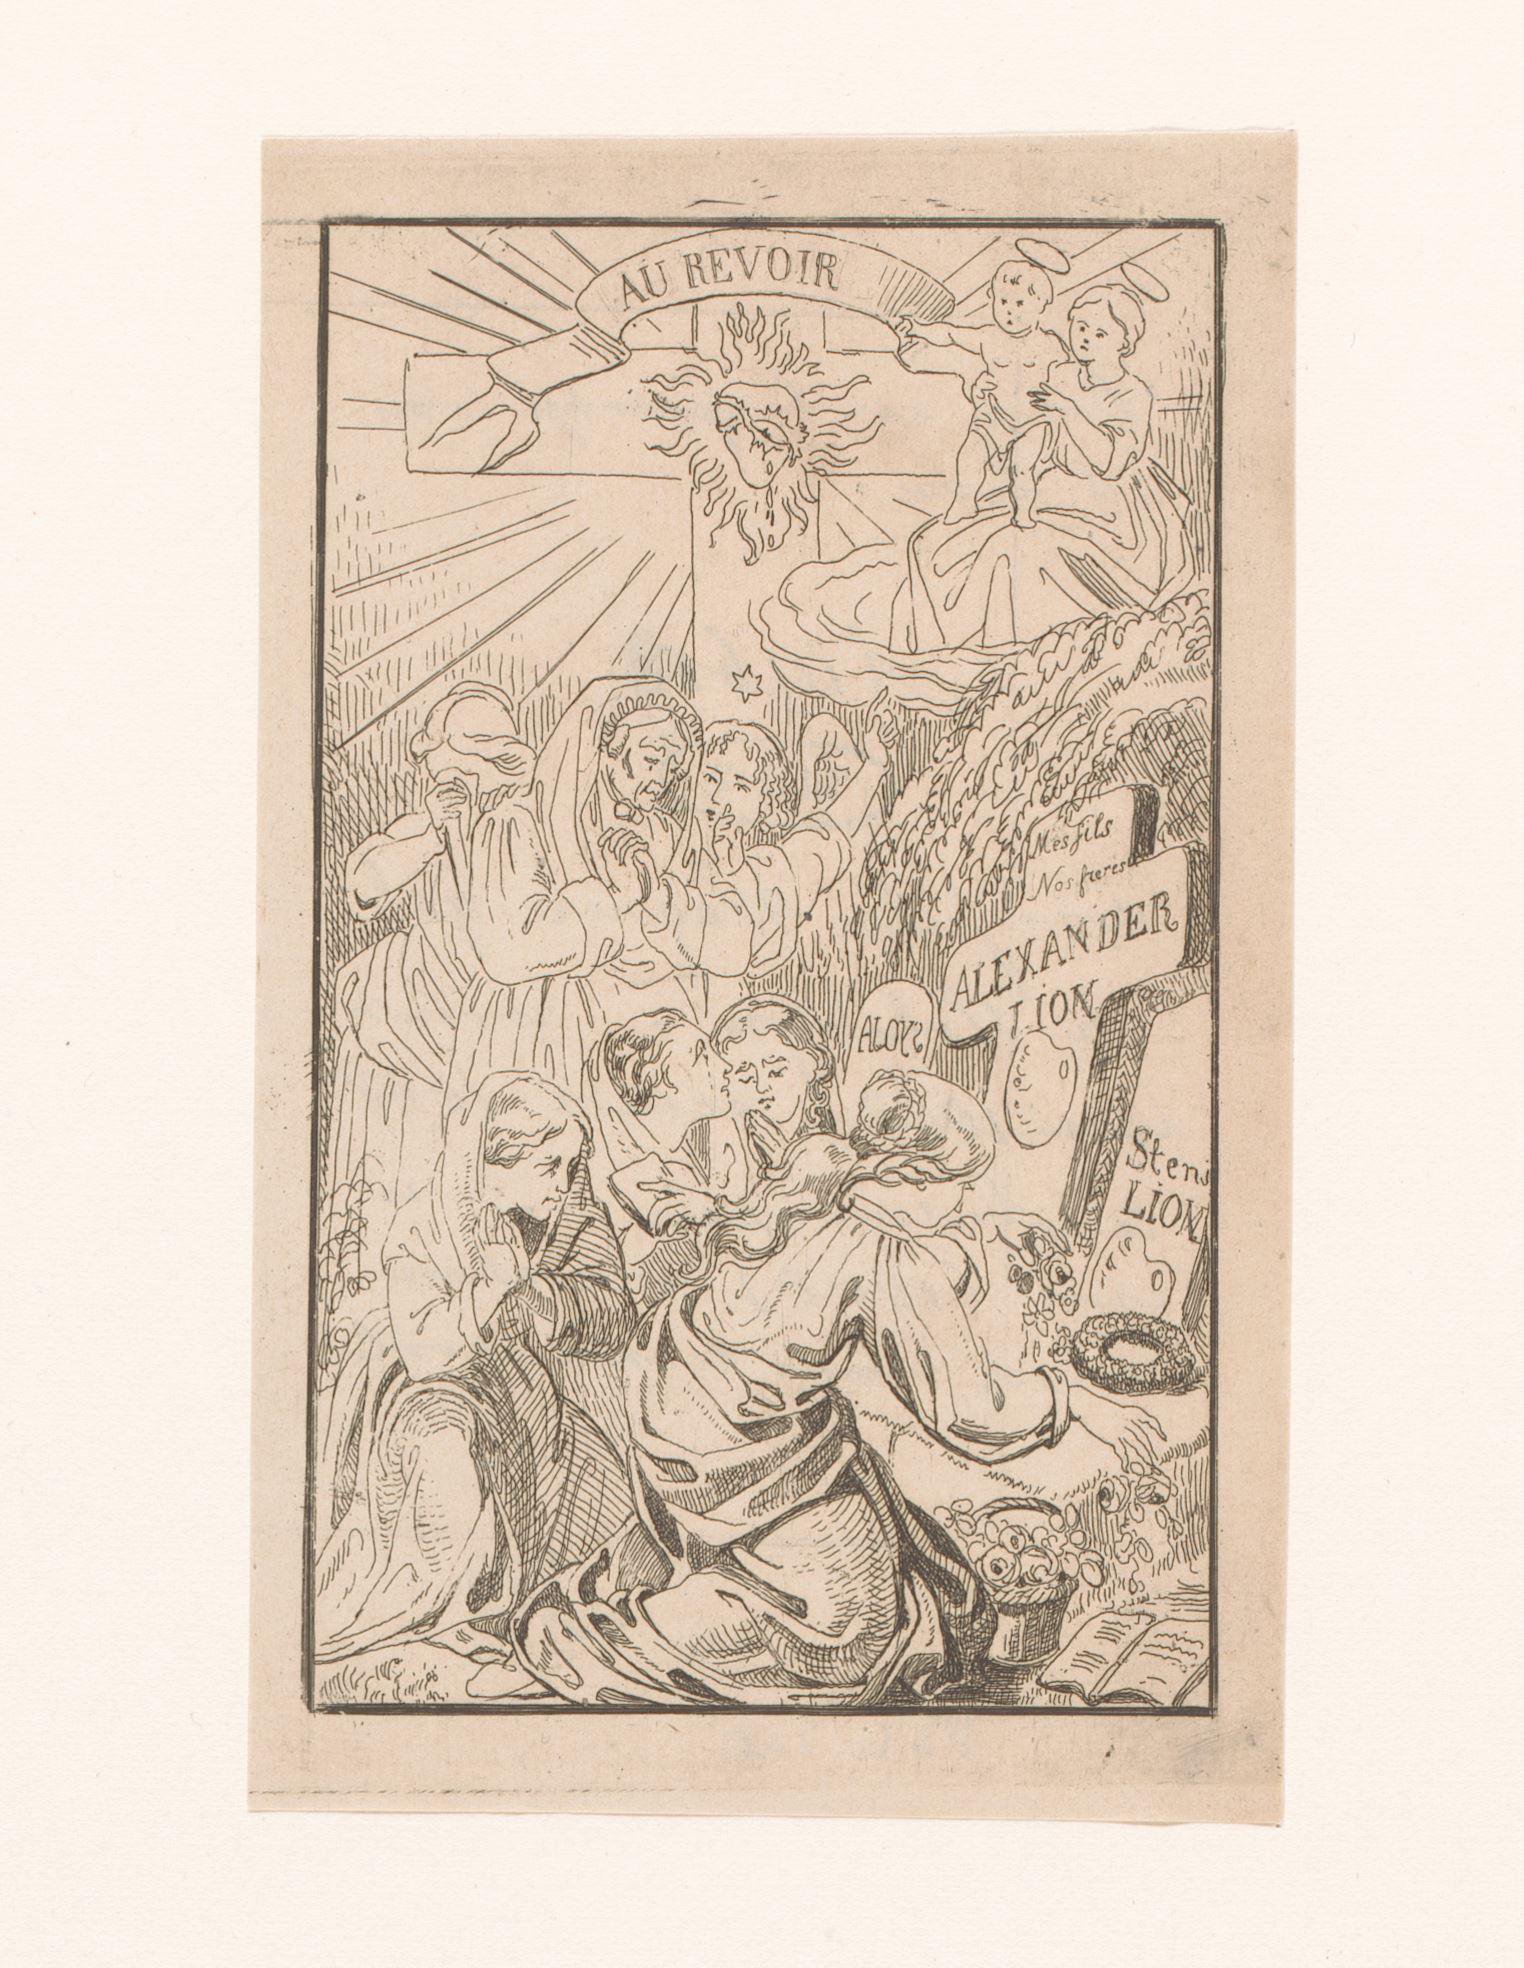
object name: prayer card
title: Bidprent voor Alexandre Louis en Aloïs Stanislas Lion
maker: julius wagner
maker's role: print maker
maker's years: 1818-1879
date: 1857-1889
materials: paper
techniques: etching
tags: antwerp, painter, brussels, alexandre louis lion, madonna (i.e. mary with the christ-child) in the air, or on the clouds, weeping, gravestone, tombstone, mourning the dead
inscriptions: collector's mark: Lugt 2228